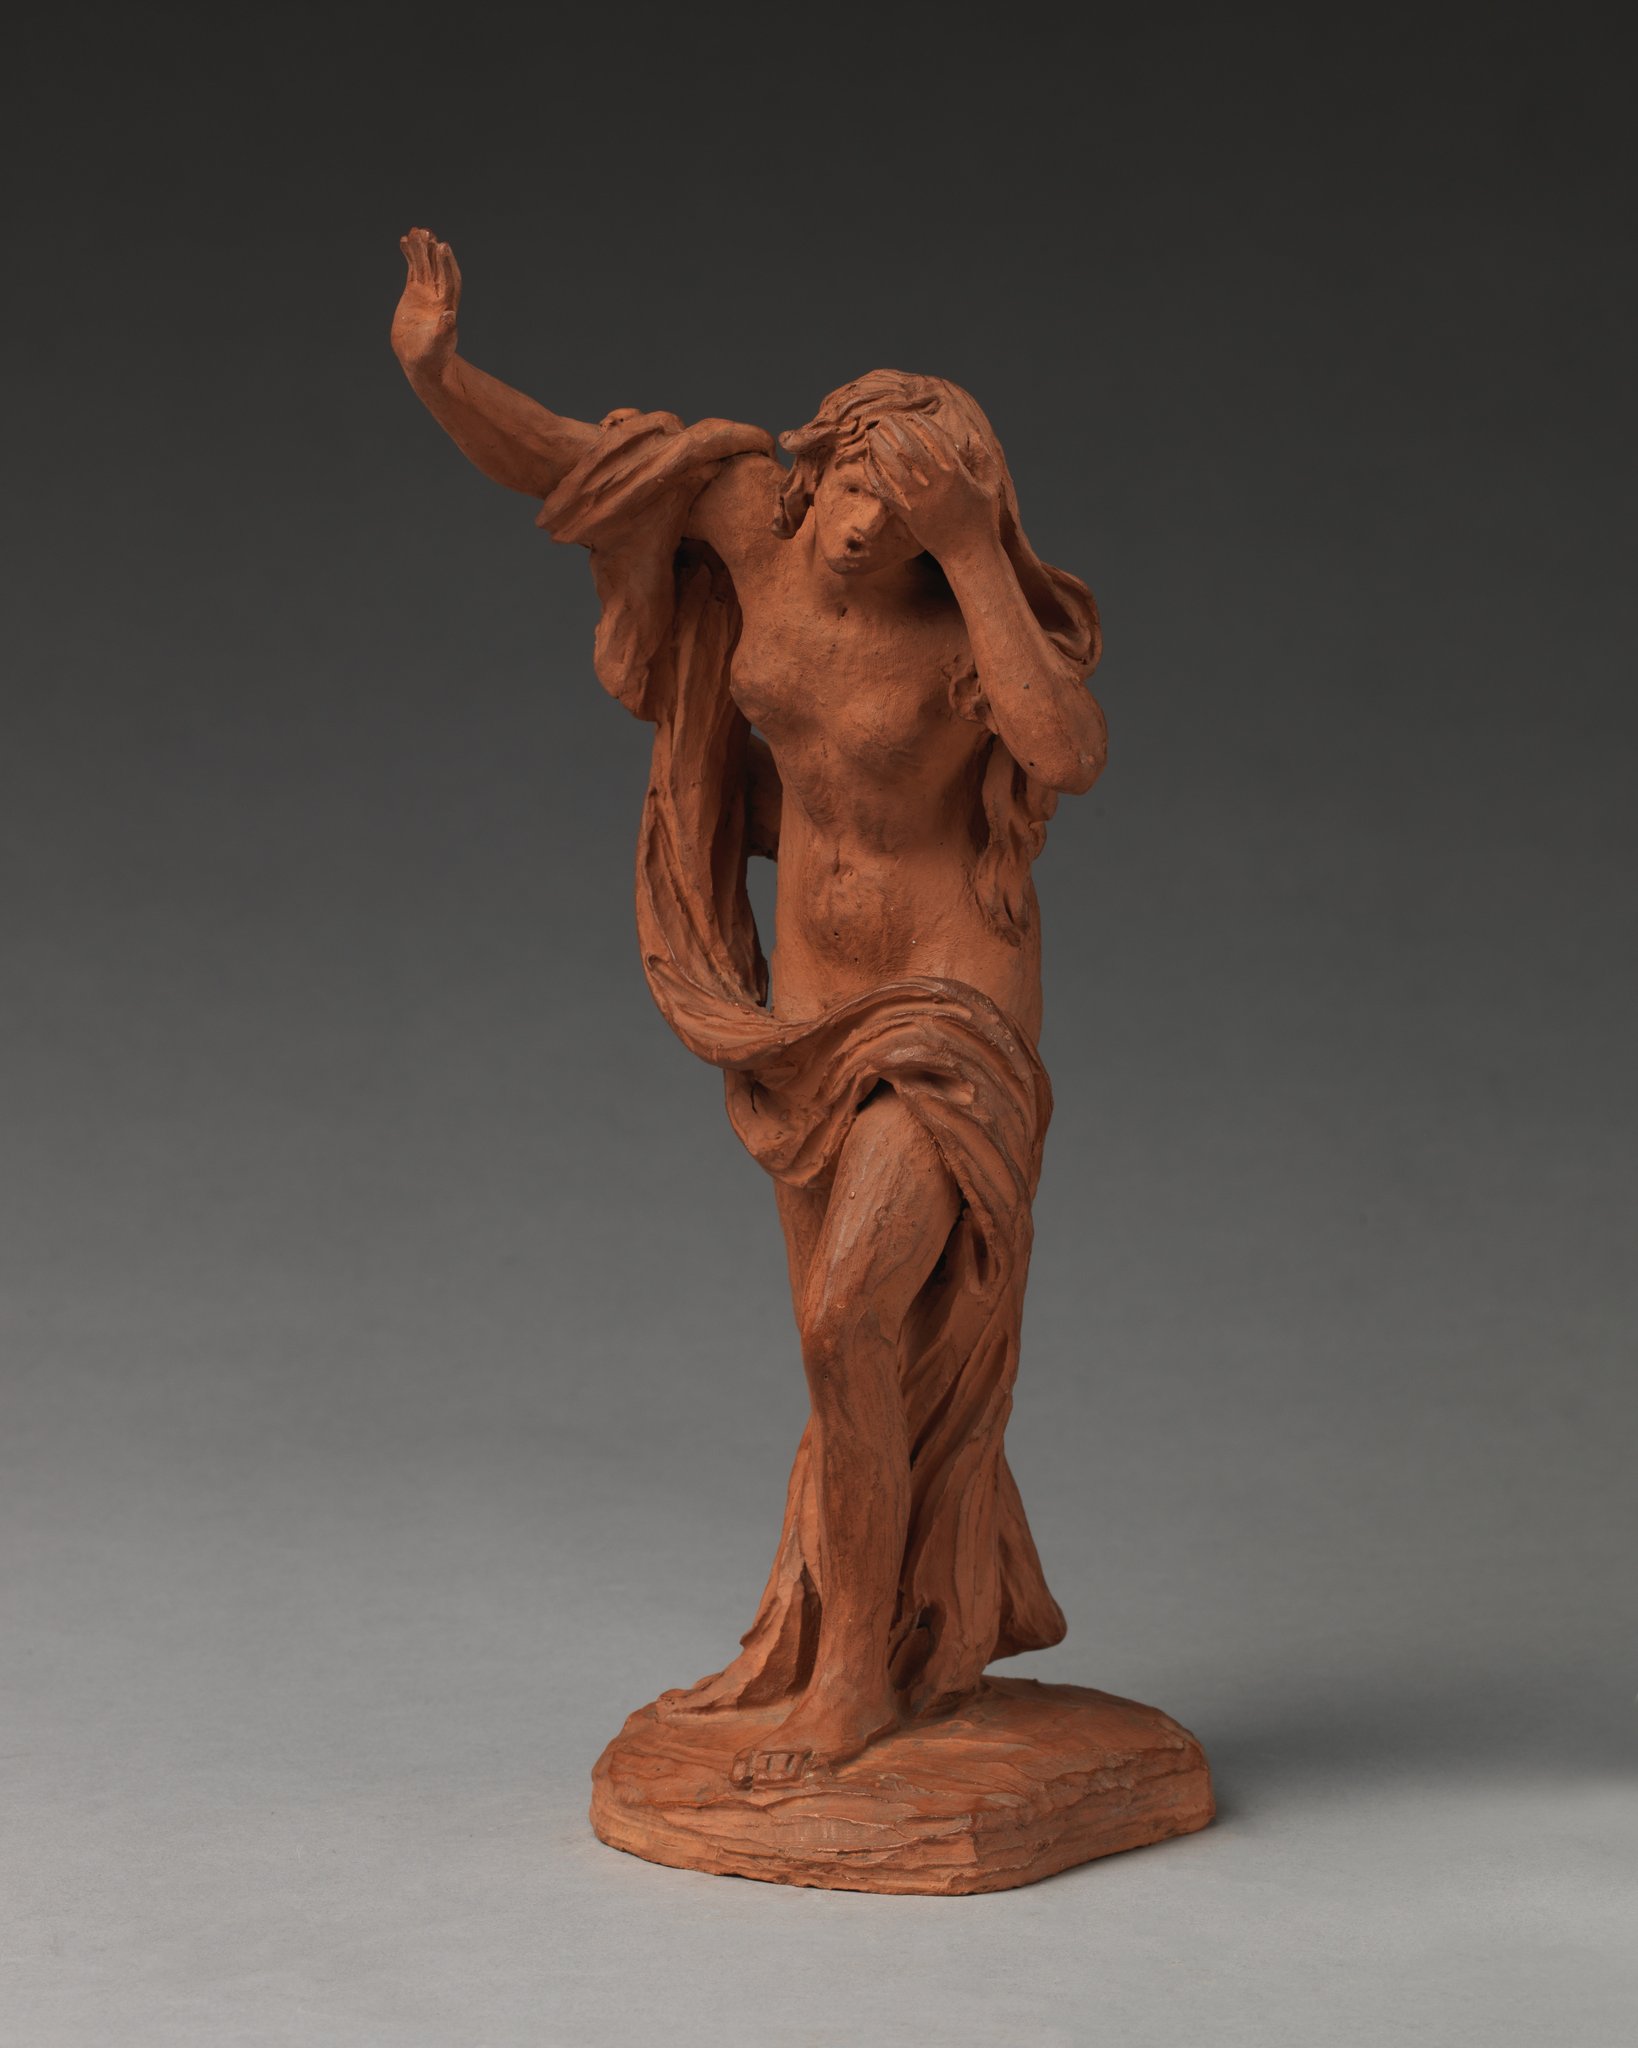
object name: figure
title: Eve Bewailing the Death of Abel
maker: joseph nollekens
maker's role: artist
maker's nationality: british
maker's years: 1737-1823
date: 1800-1810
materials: terracotta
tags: sadness,eve